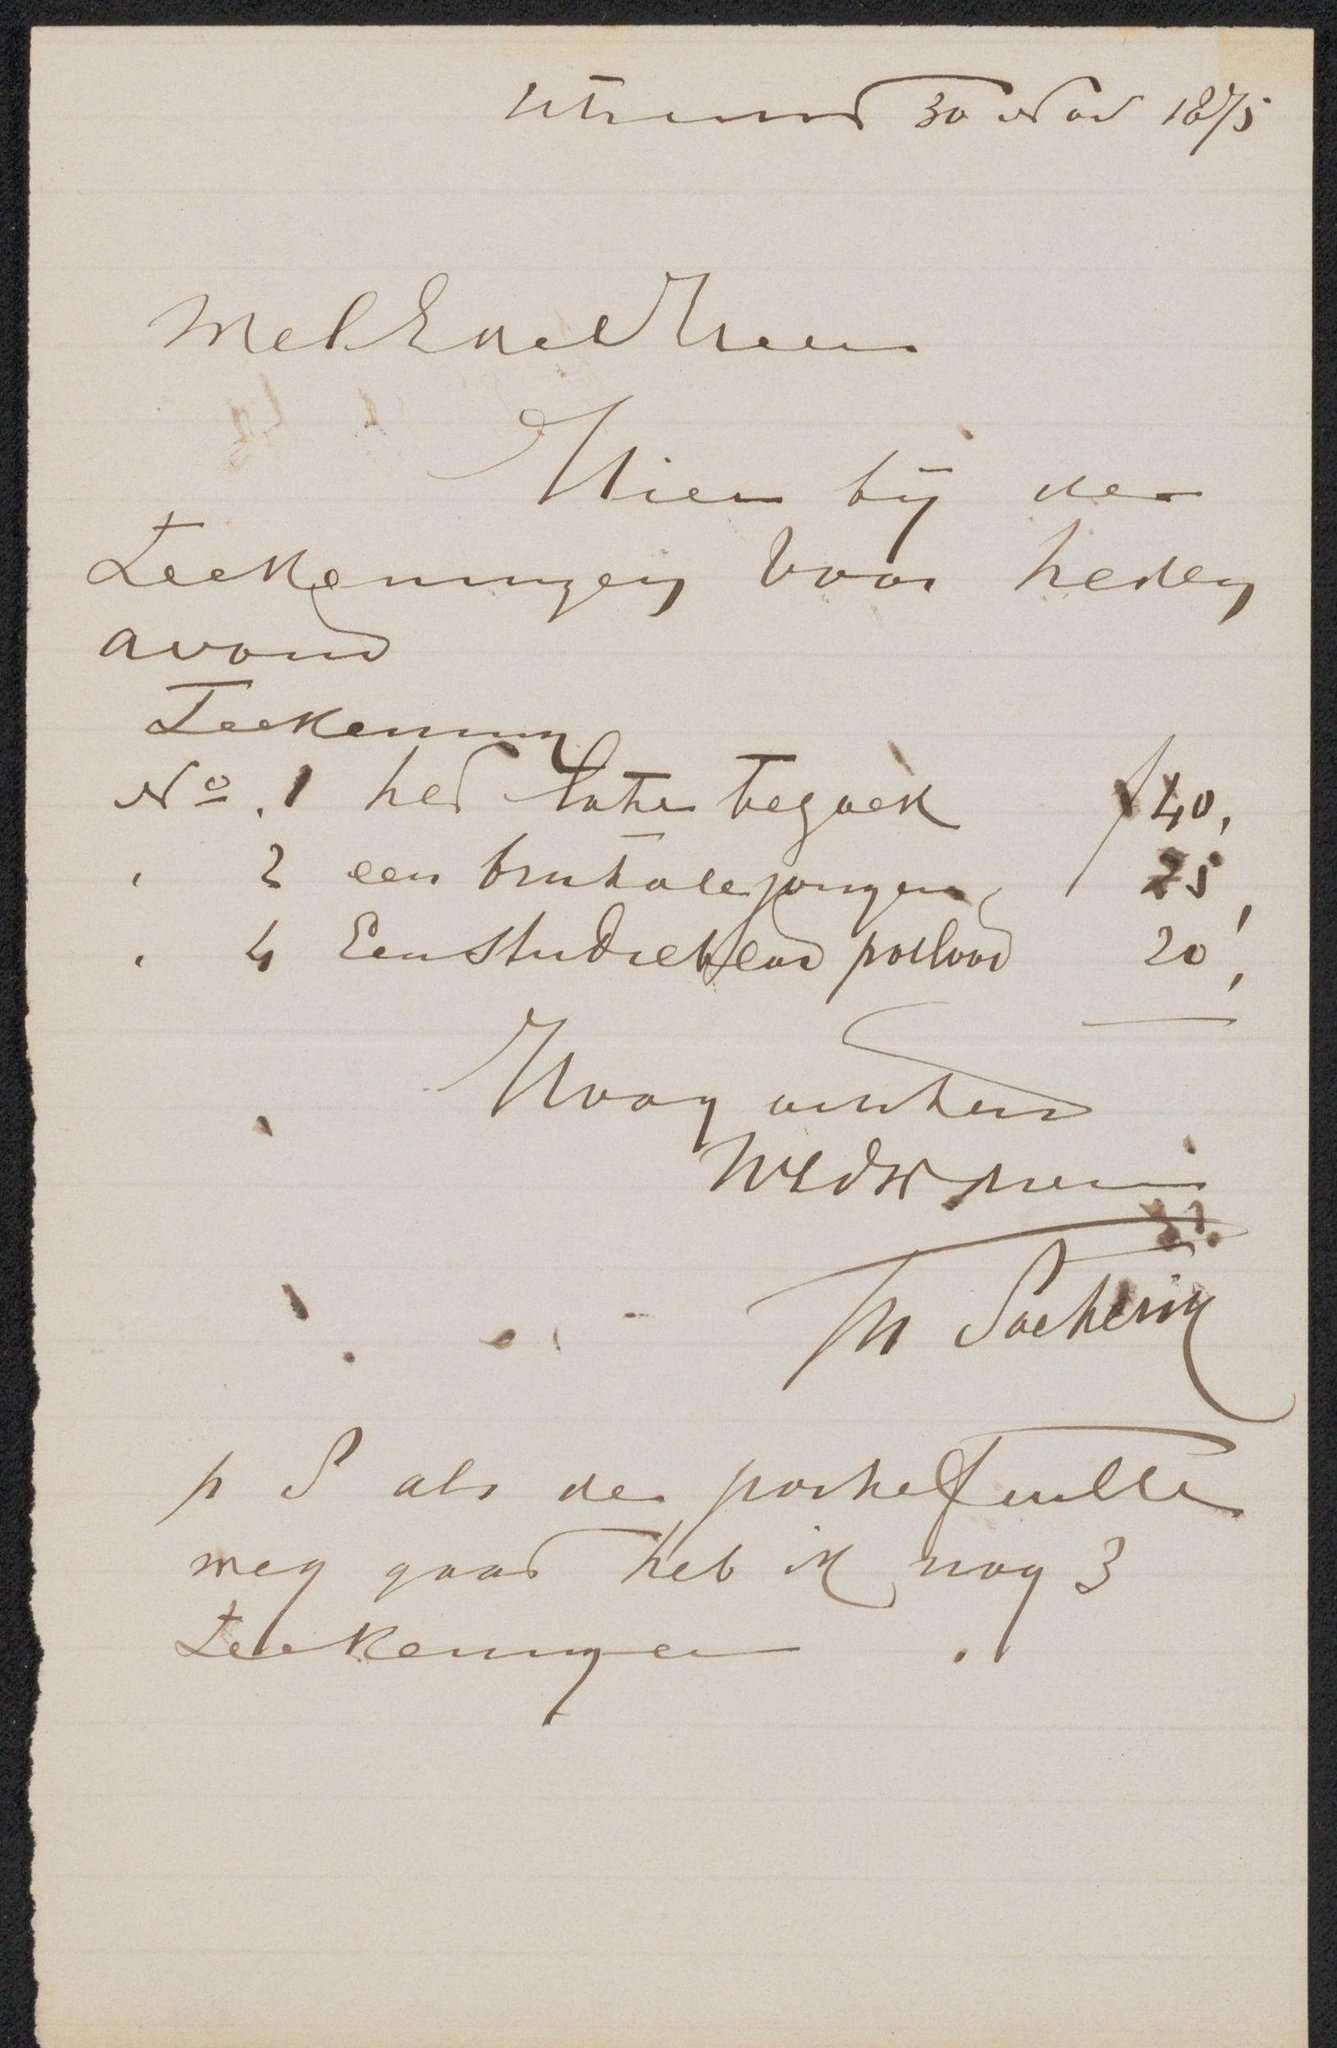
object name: letter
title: Brief aan anoniem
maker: theodoor soeterik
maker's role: draughtsman, print maker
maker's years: 1810-1883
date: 1875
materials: ink, paper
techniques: pen, writing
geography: utrecht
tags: drawing, money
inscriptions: collector's mark: ‘RPK’